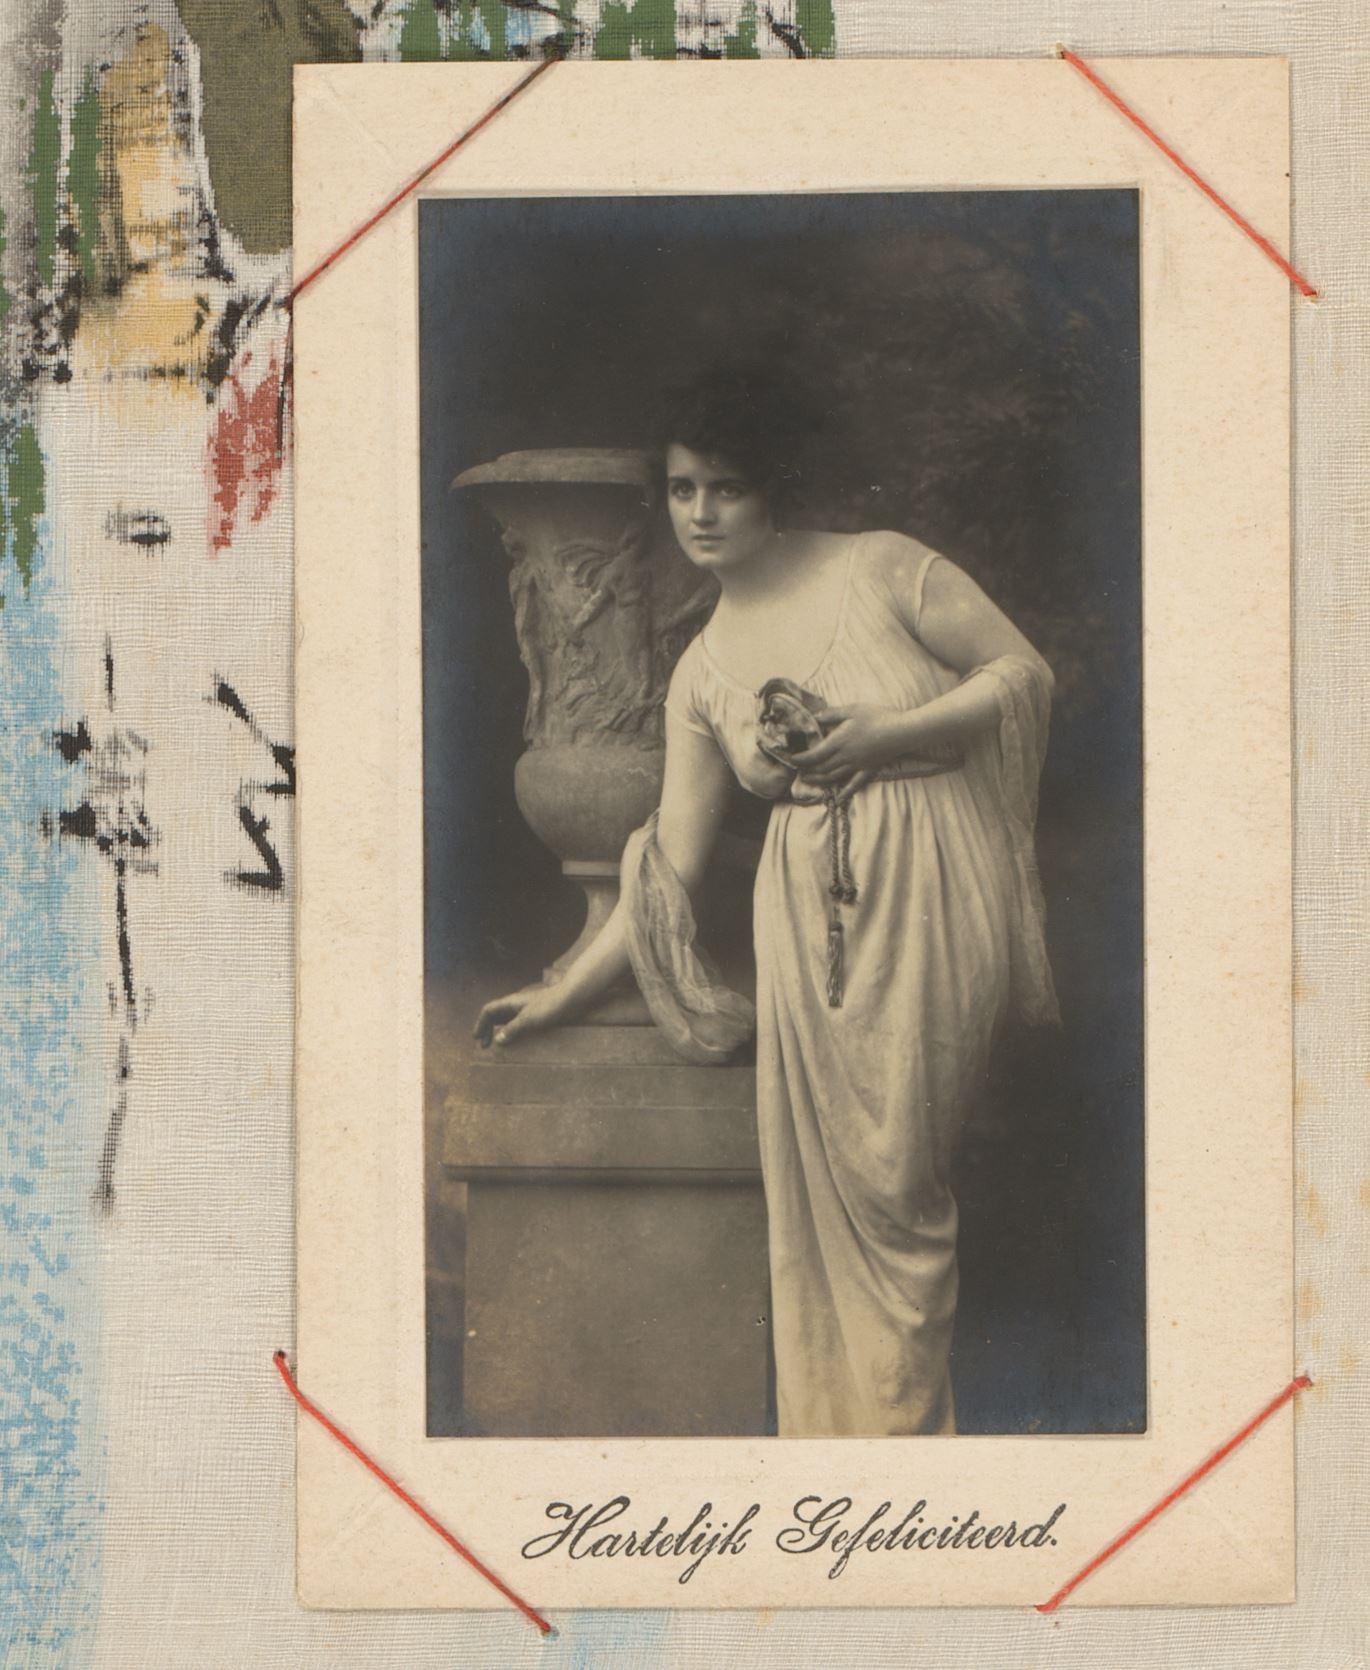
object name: ansichtkaart, prentbriefkaart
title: Portret van een vrouw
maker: Anonymous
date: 1880-1920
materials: paint, photographic support, silk, textile, watercolor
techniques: brush, gelatin silver print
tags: adult woman, historical persons